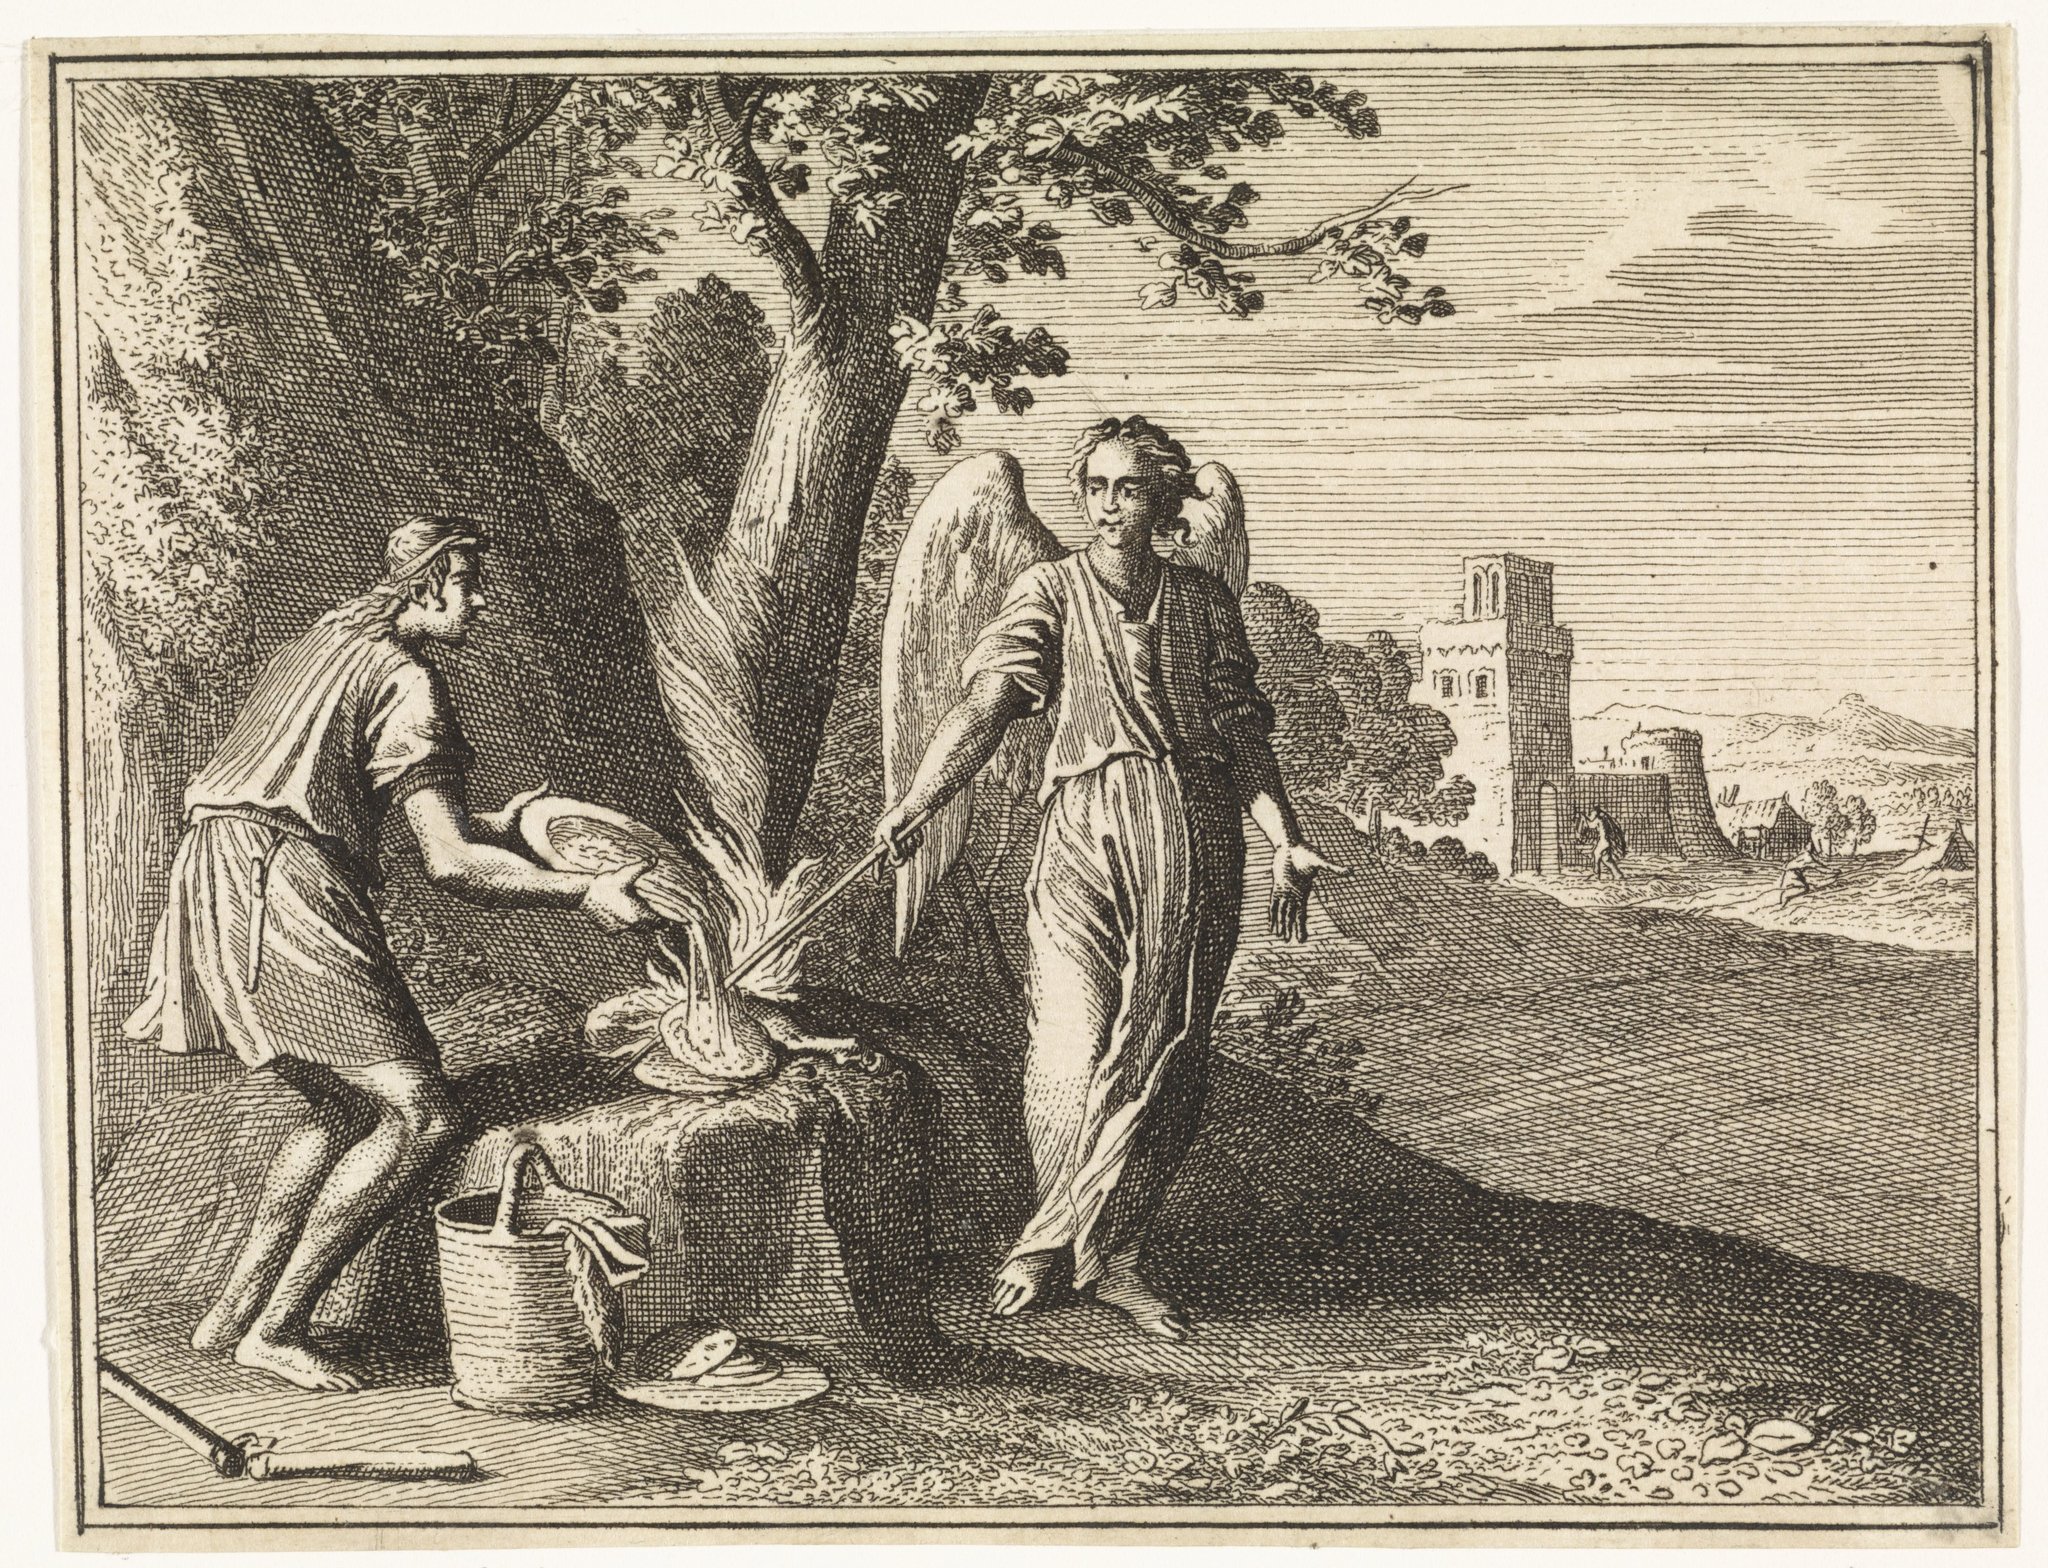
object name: print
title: Engel des Heren verschijnt aan Gideon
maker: caspar luyken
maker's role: draughtsman, print maker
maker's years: 1672-1708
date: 1712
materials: paper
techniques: etching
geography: amsterdam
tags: gideon and the angel of the lord (judges 6:11-24)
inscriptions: number: ‘82’, collector's mark: Lugt 2228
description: Illustratie uit: Luyken, Jan. De schriftuurlyke geschiedenissen en gelykenissen van het Oude en Nieuwe Verbond, 2 delen. Amsterdam: Wed. Pieter Arentsz II en Cornelis van der Sys, 1712, dl. I.